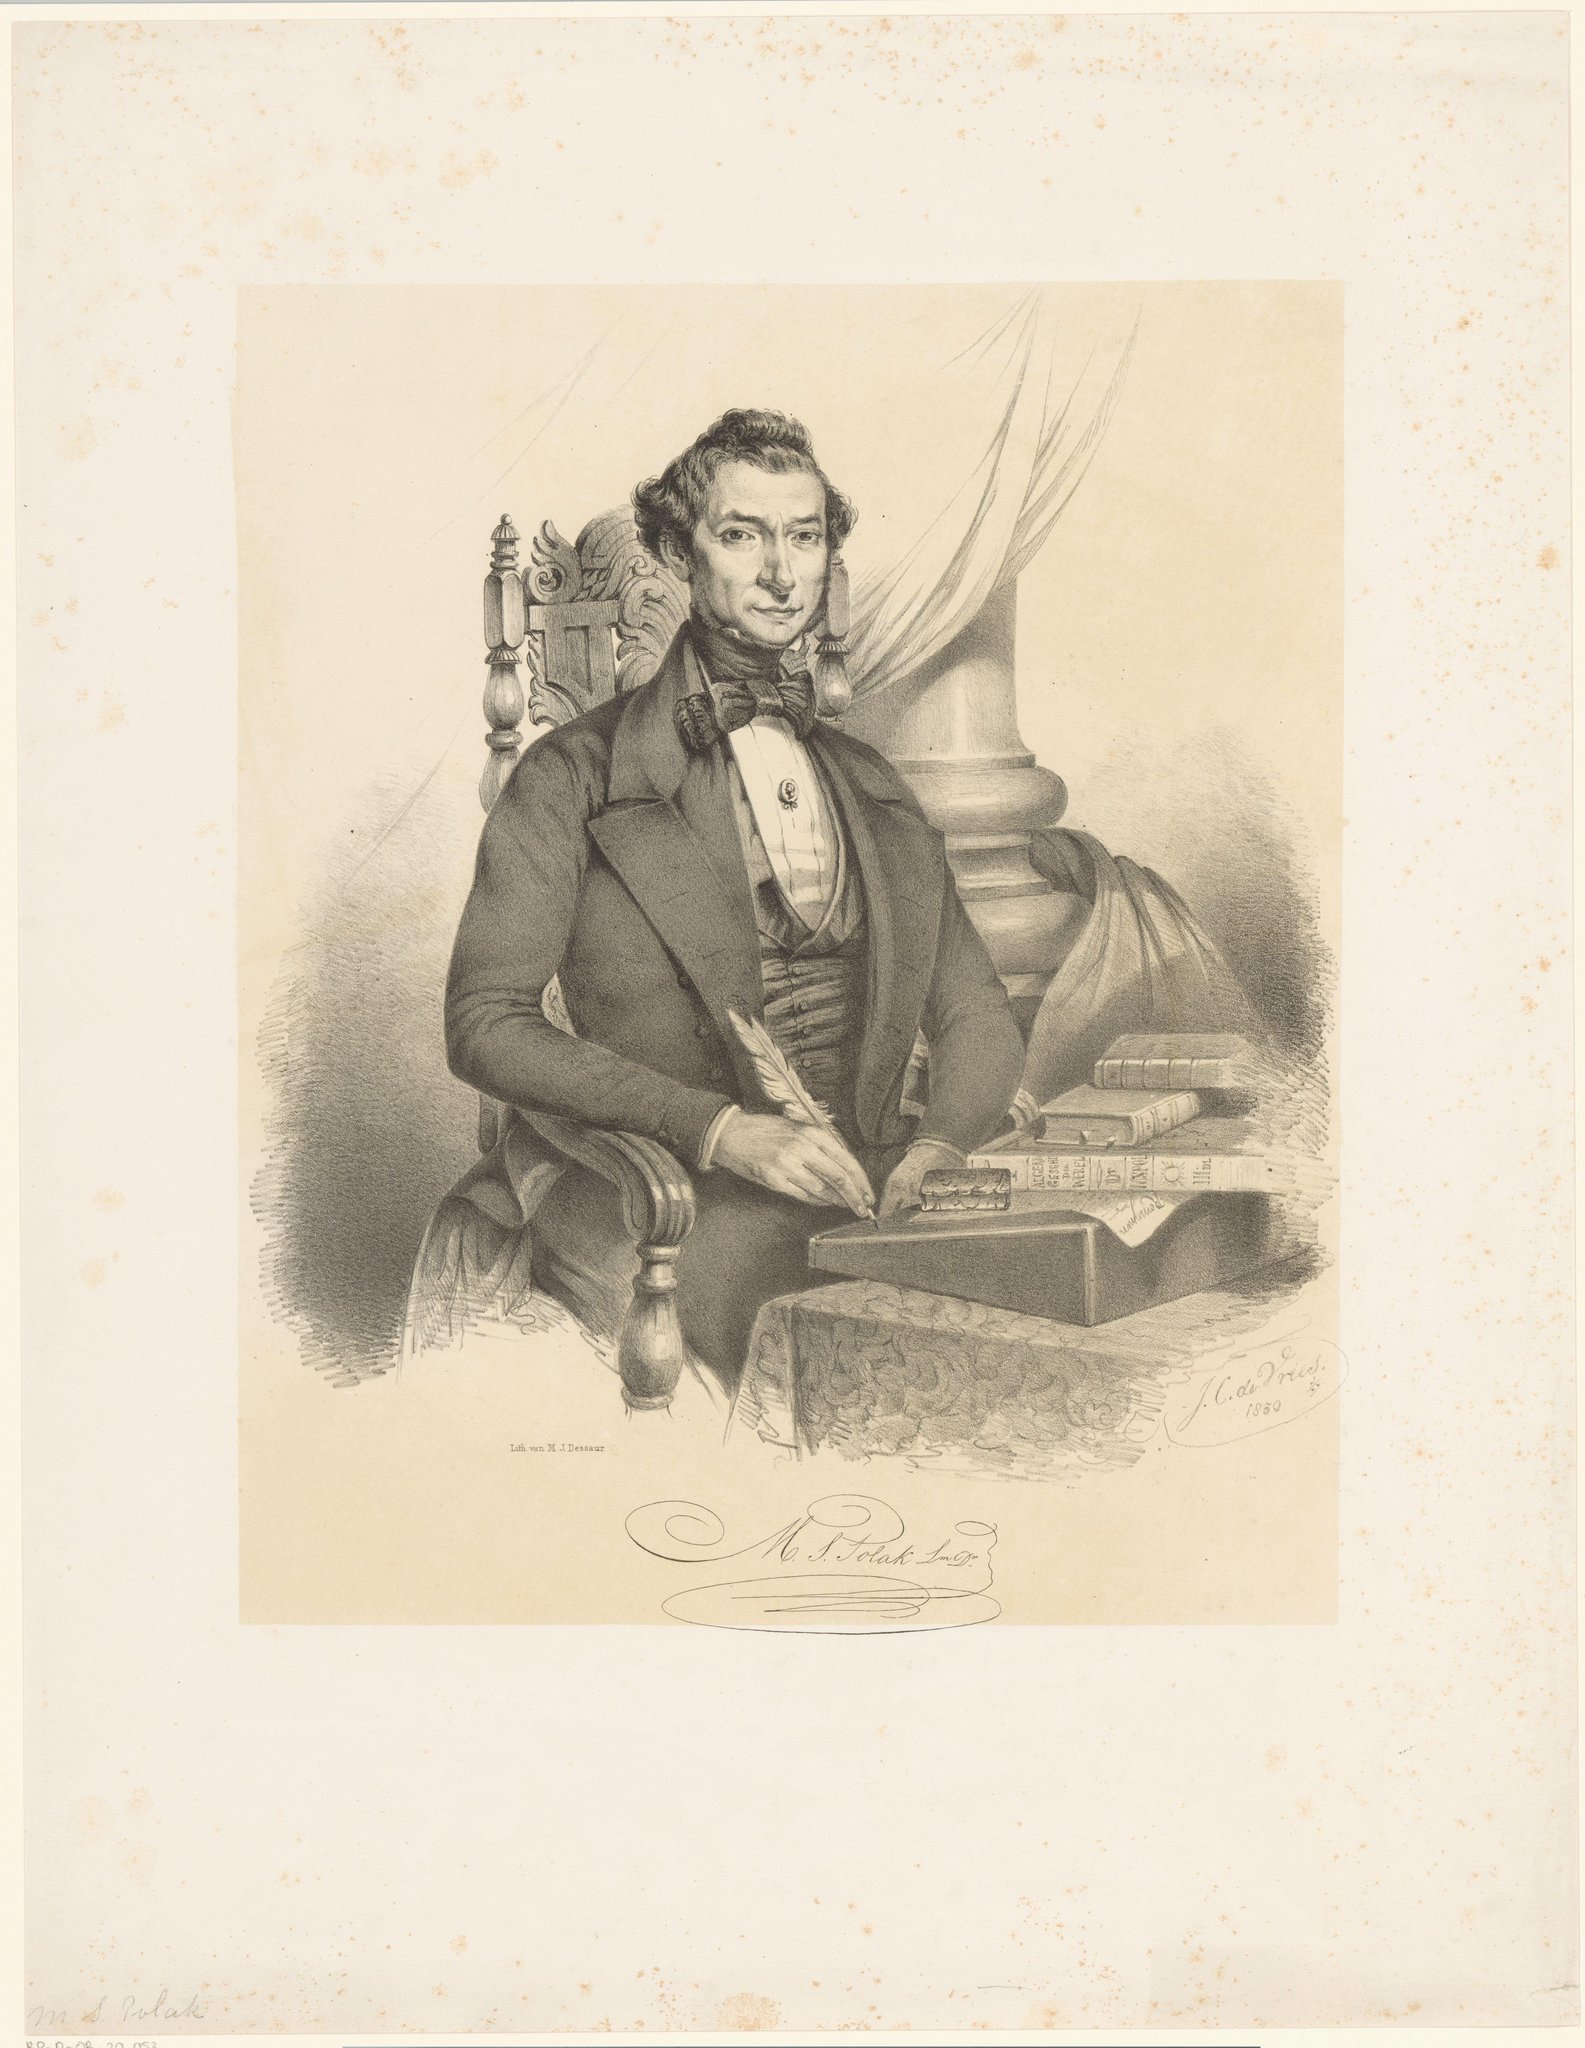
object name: print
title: Portret van Mozes Salomon Polak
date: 1850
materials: paper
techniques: tone lithography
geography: amsterdam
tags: amsterdam, historical persons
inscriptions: collector's mark: Lugt 2228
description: Onder het portret de signatuur van de geportretteerde.